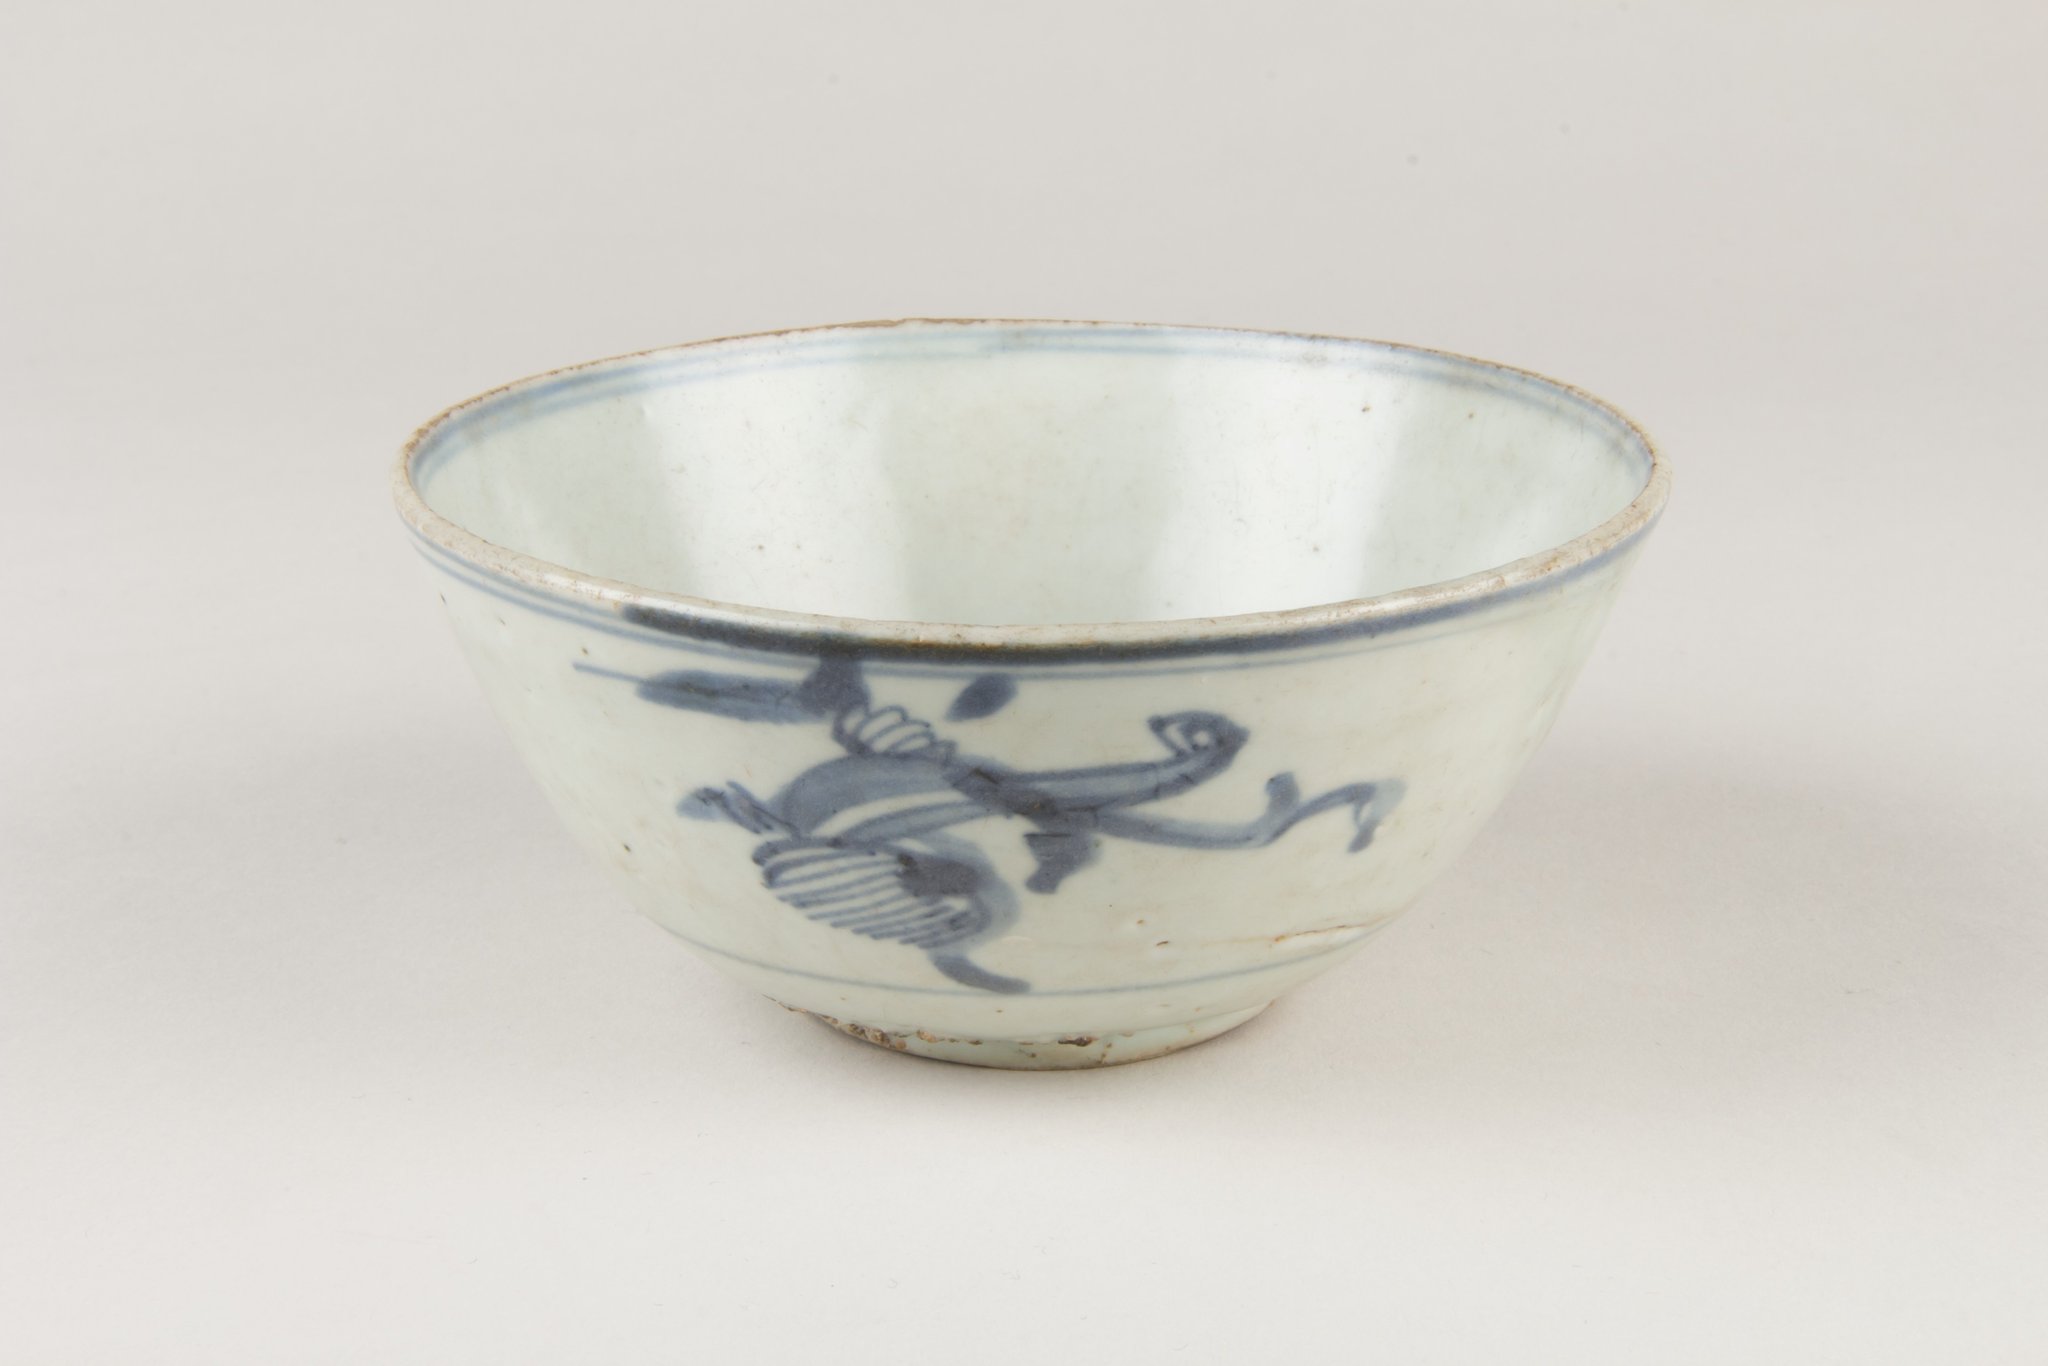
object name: bowl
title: Bowl with dragon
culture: chinese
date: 1567-1633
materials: cobalt, porcelain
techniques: painting, underglaze